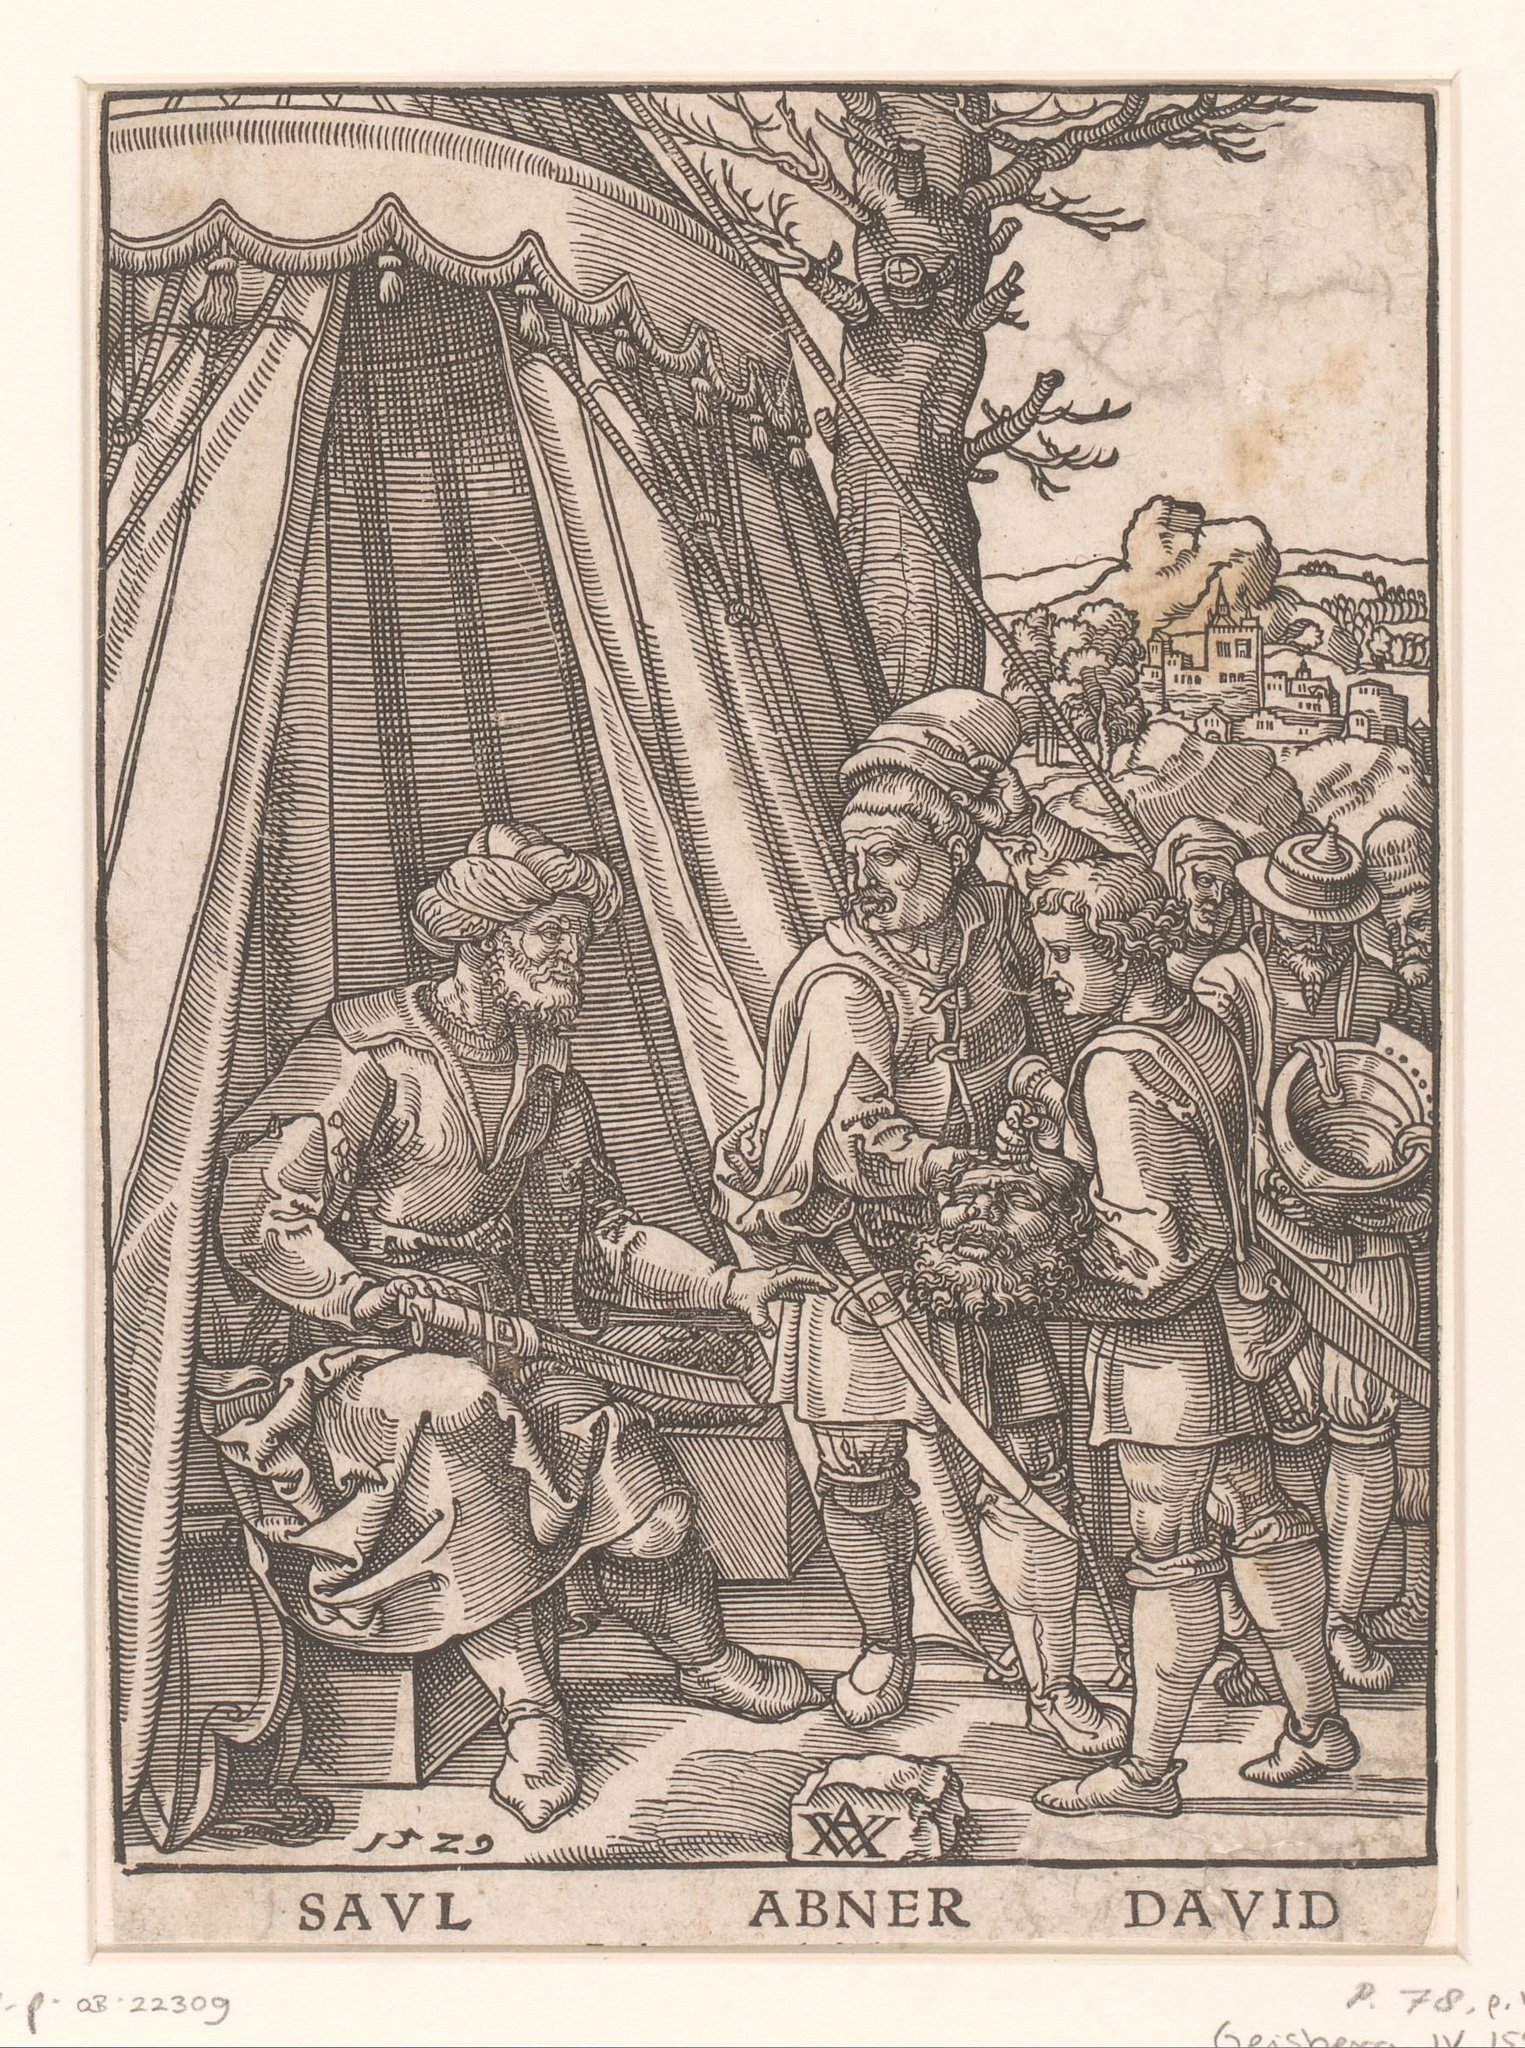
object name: print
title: Bijbelse voorstellingen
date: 1529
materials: paper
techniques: woodcut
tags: david brings goliath's head to saul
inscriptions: collector's mark: Lugt 240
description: Vierde prent in een reeks van mogelijk tien.